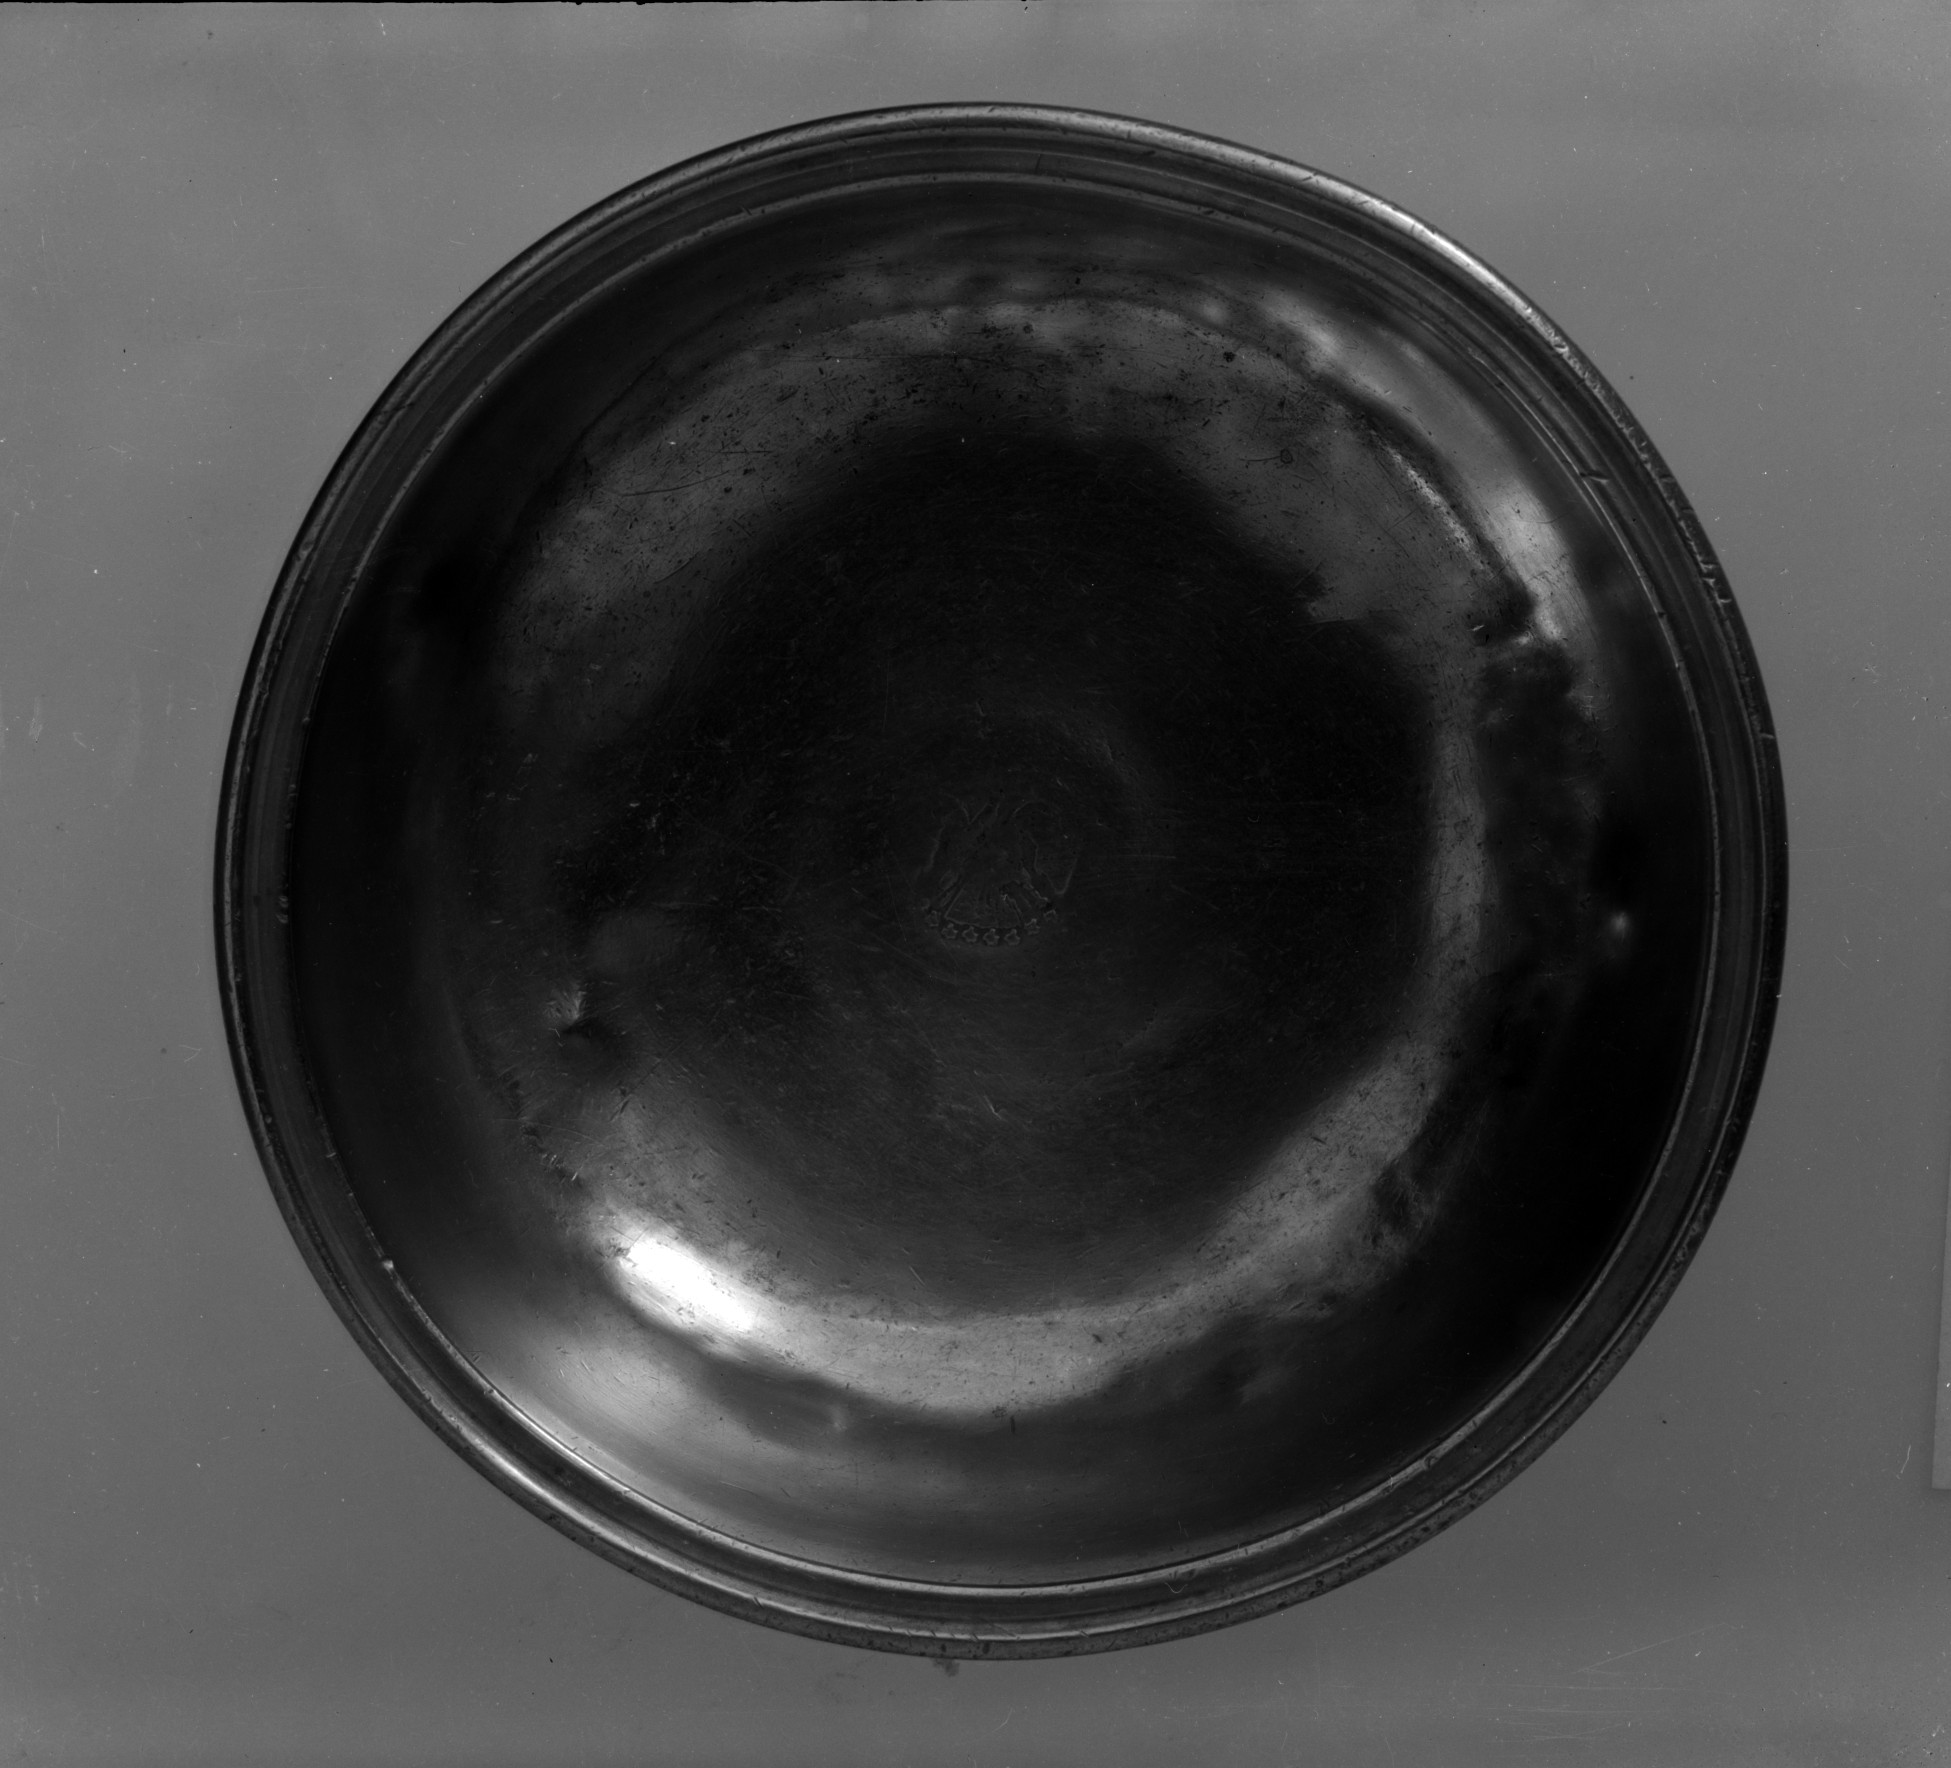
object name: basin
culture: american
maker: gershom jones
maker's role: maker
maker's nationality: american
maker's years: 1751-1809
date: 1770-1800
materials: pewter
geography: united states